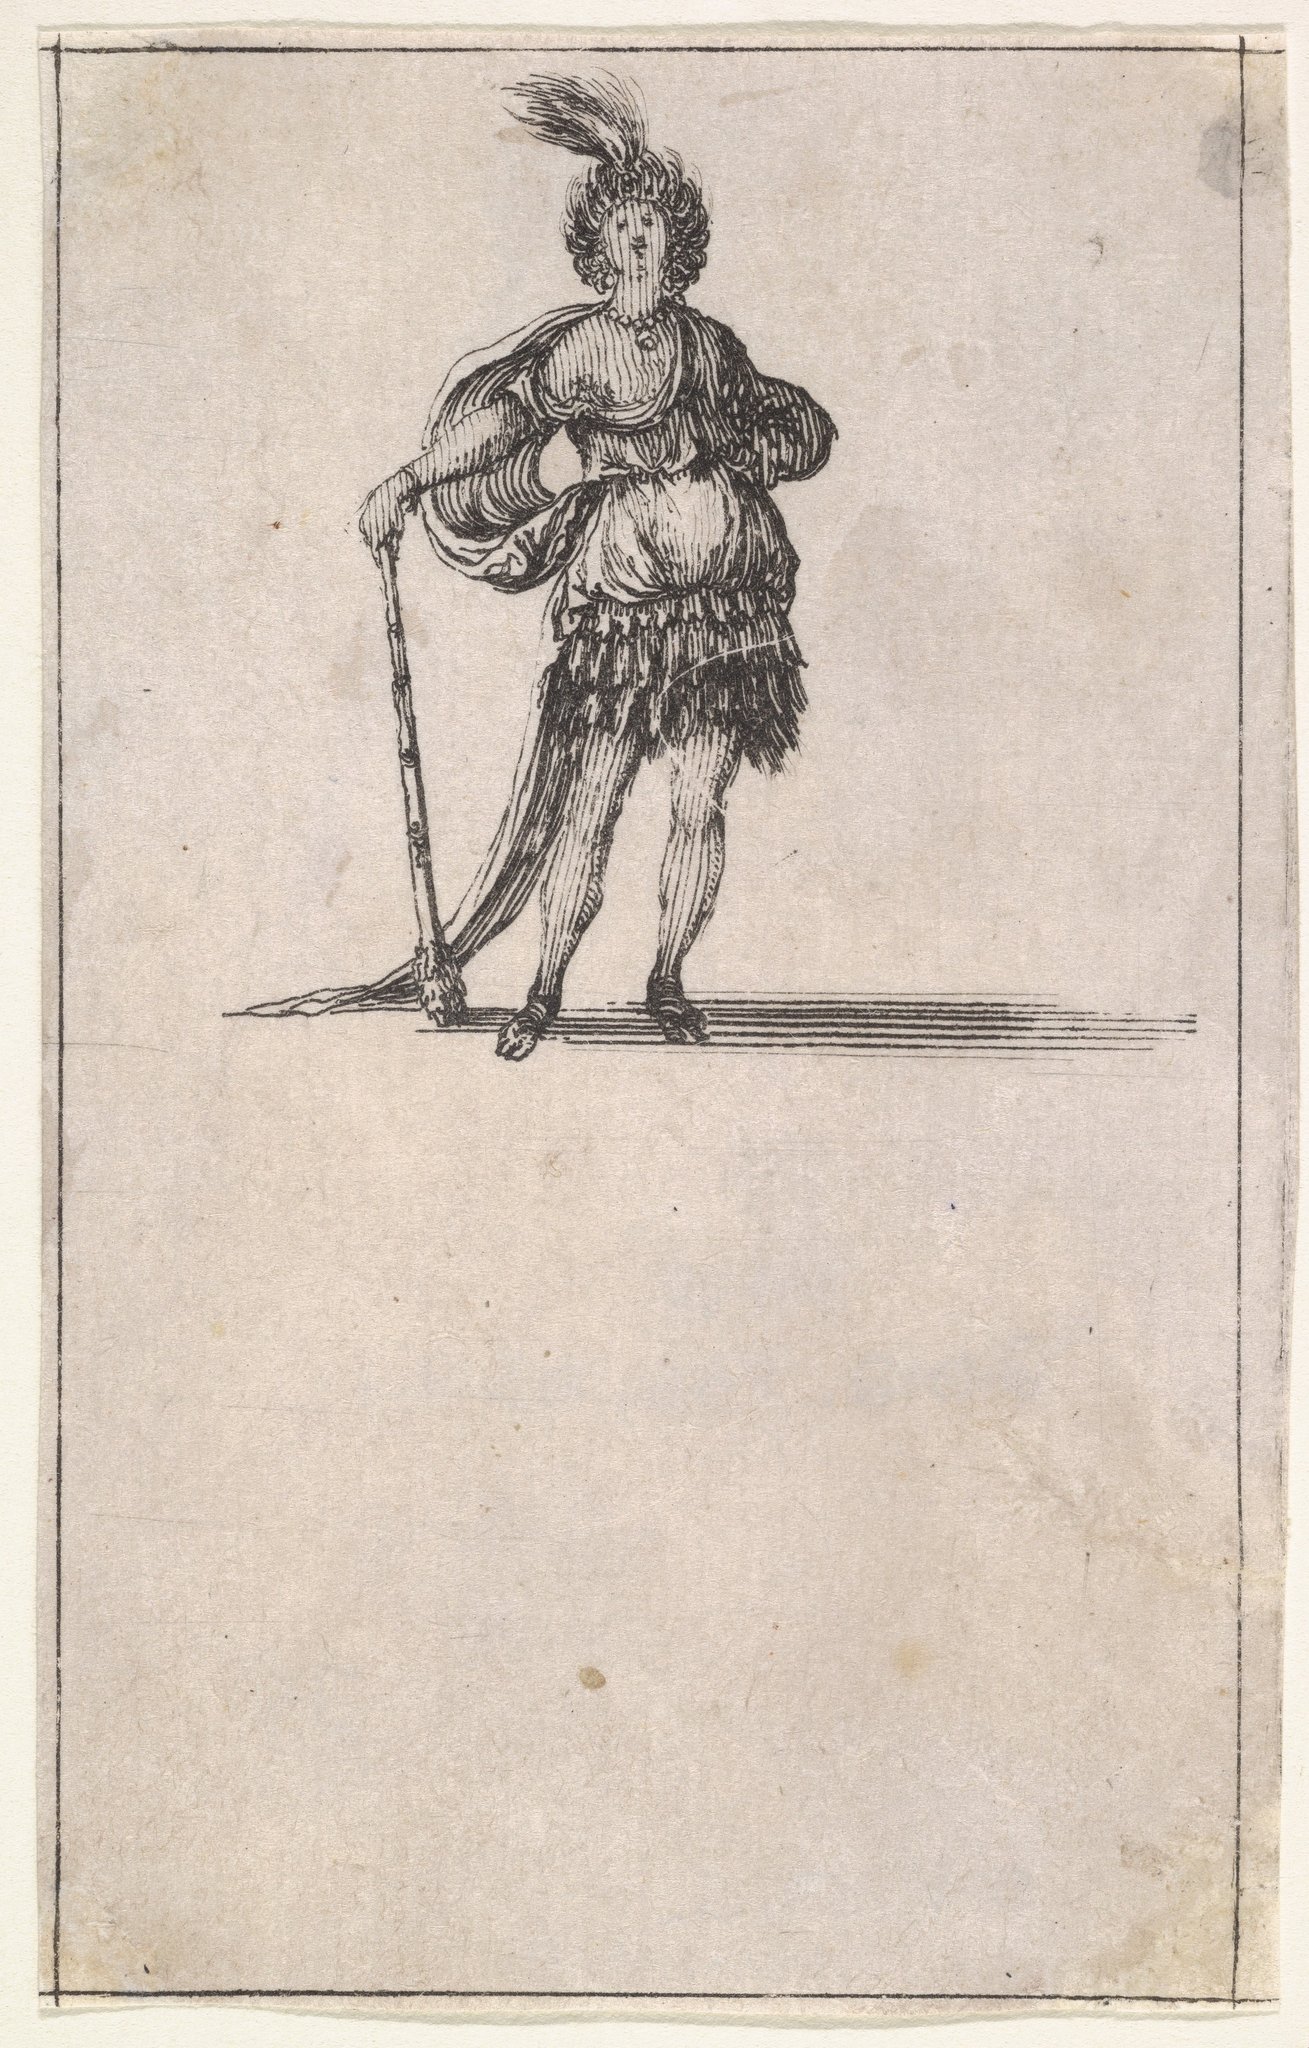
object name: print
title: Numidie, from "Game of Geography" (Jeu de la Géographie)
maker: stefano della bella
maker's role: artist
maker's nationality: italian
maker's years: 1610-1664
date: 1644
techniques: etching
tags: portraits,women